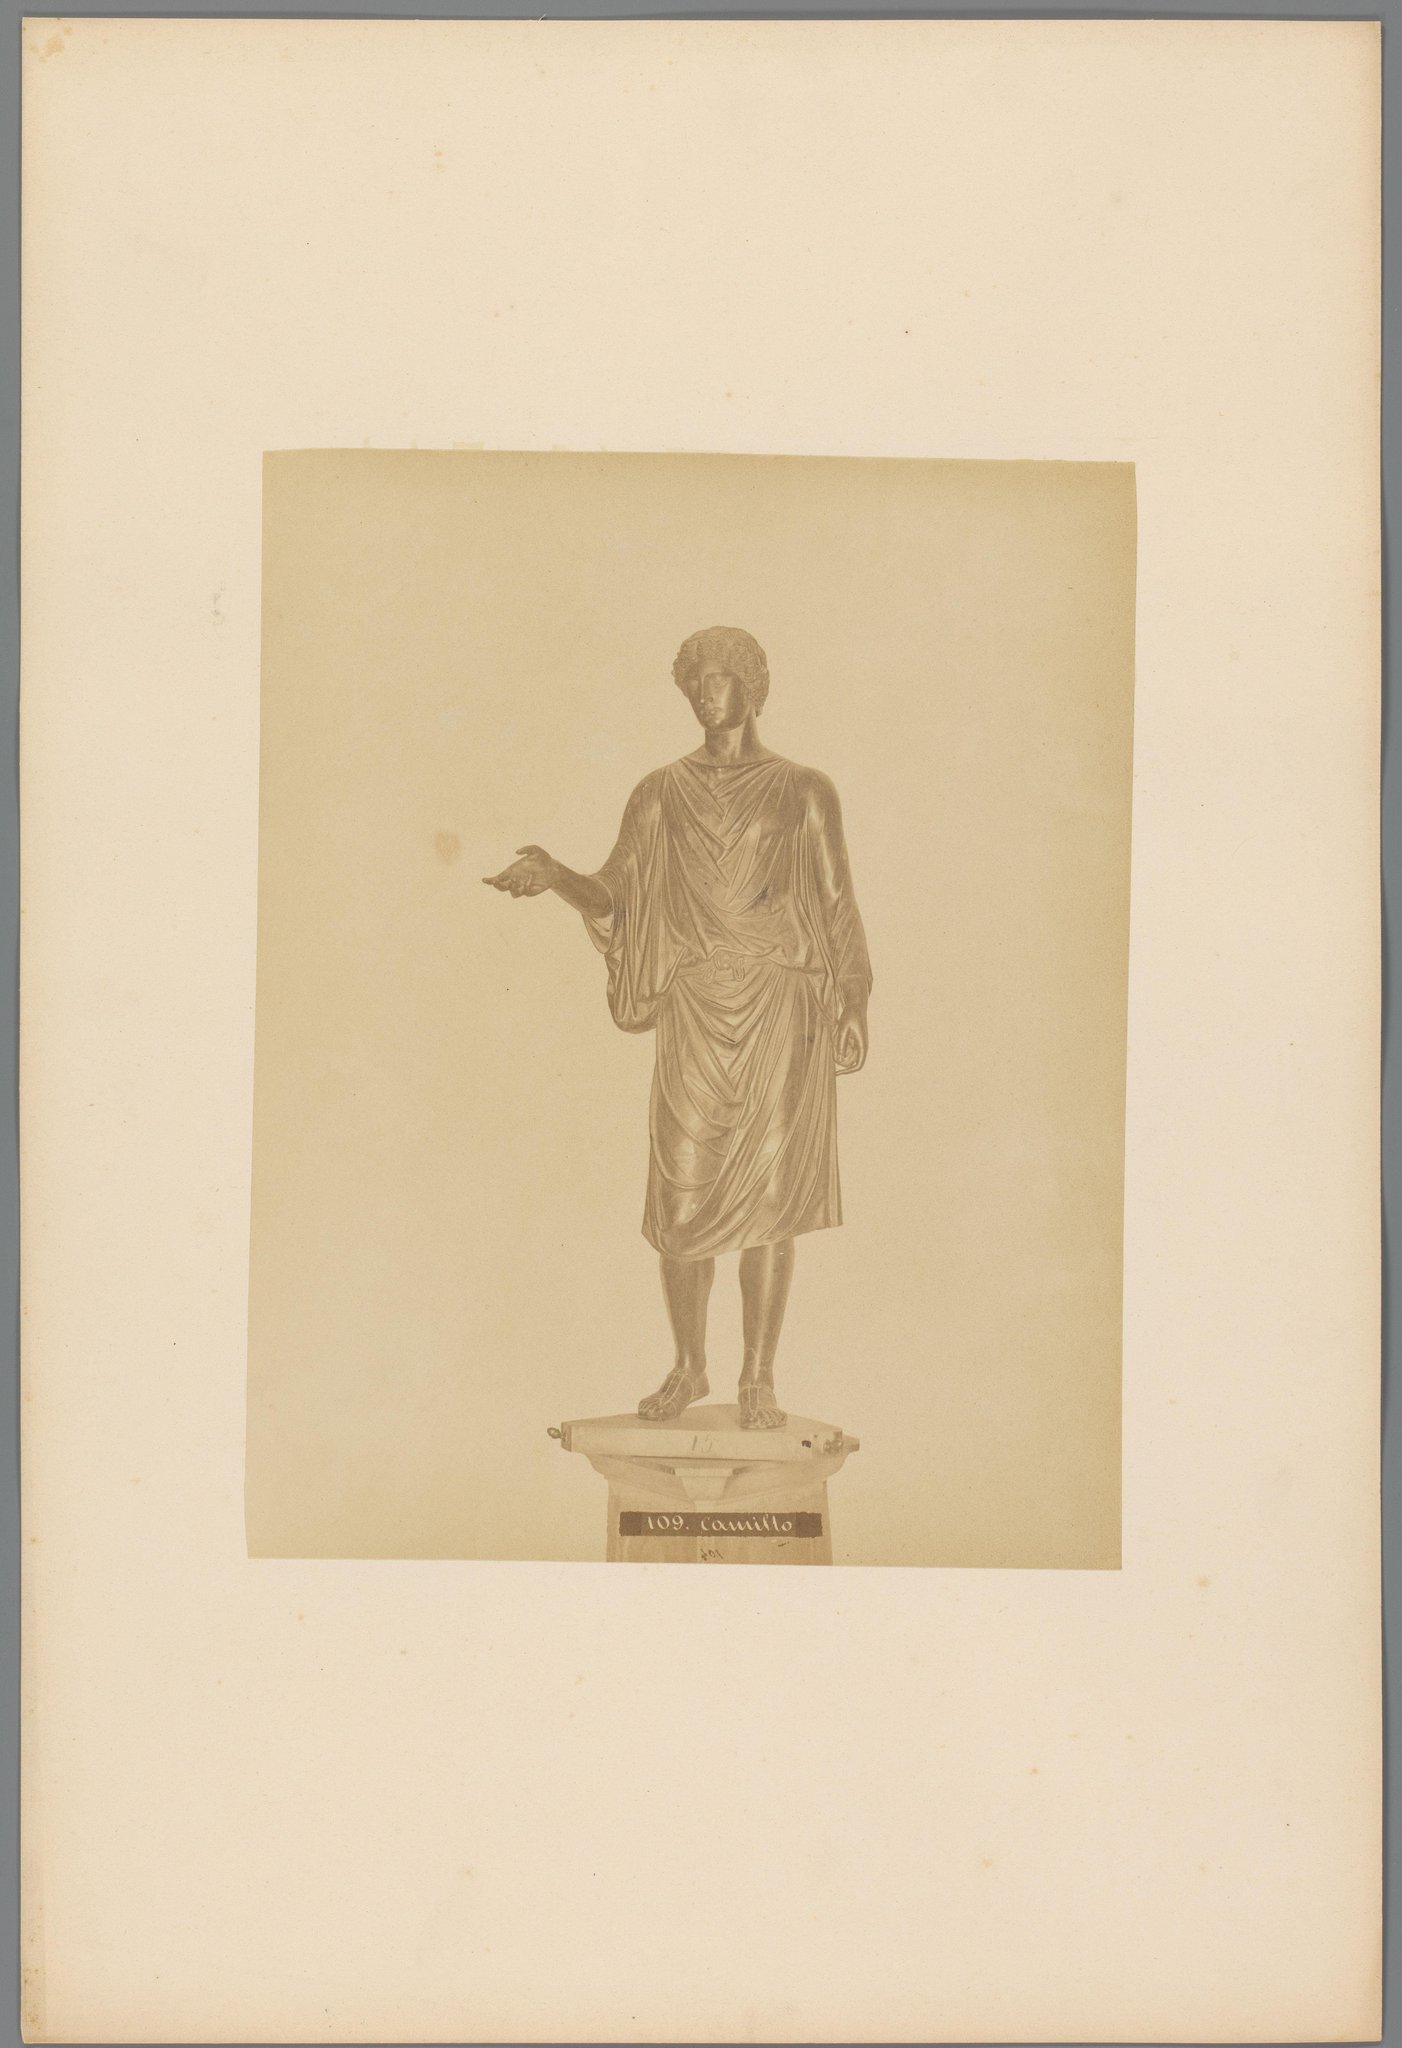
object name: photograph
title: Camillo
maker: Anonymous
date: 1851-1900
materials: cardboard, paper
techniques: albumen print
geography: rome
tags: piece of sculpture, reproduction of a piece of sculpture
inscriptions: number: ‘109.’